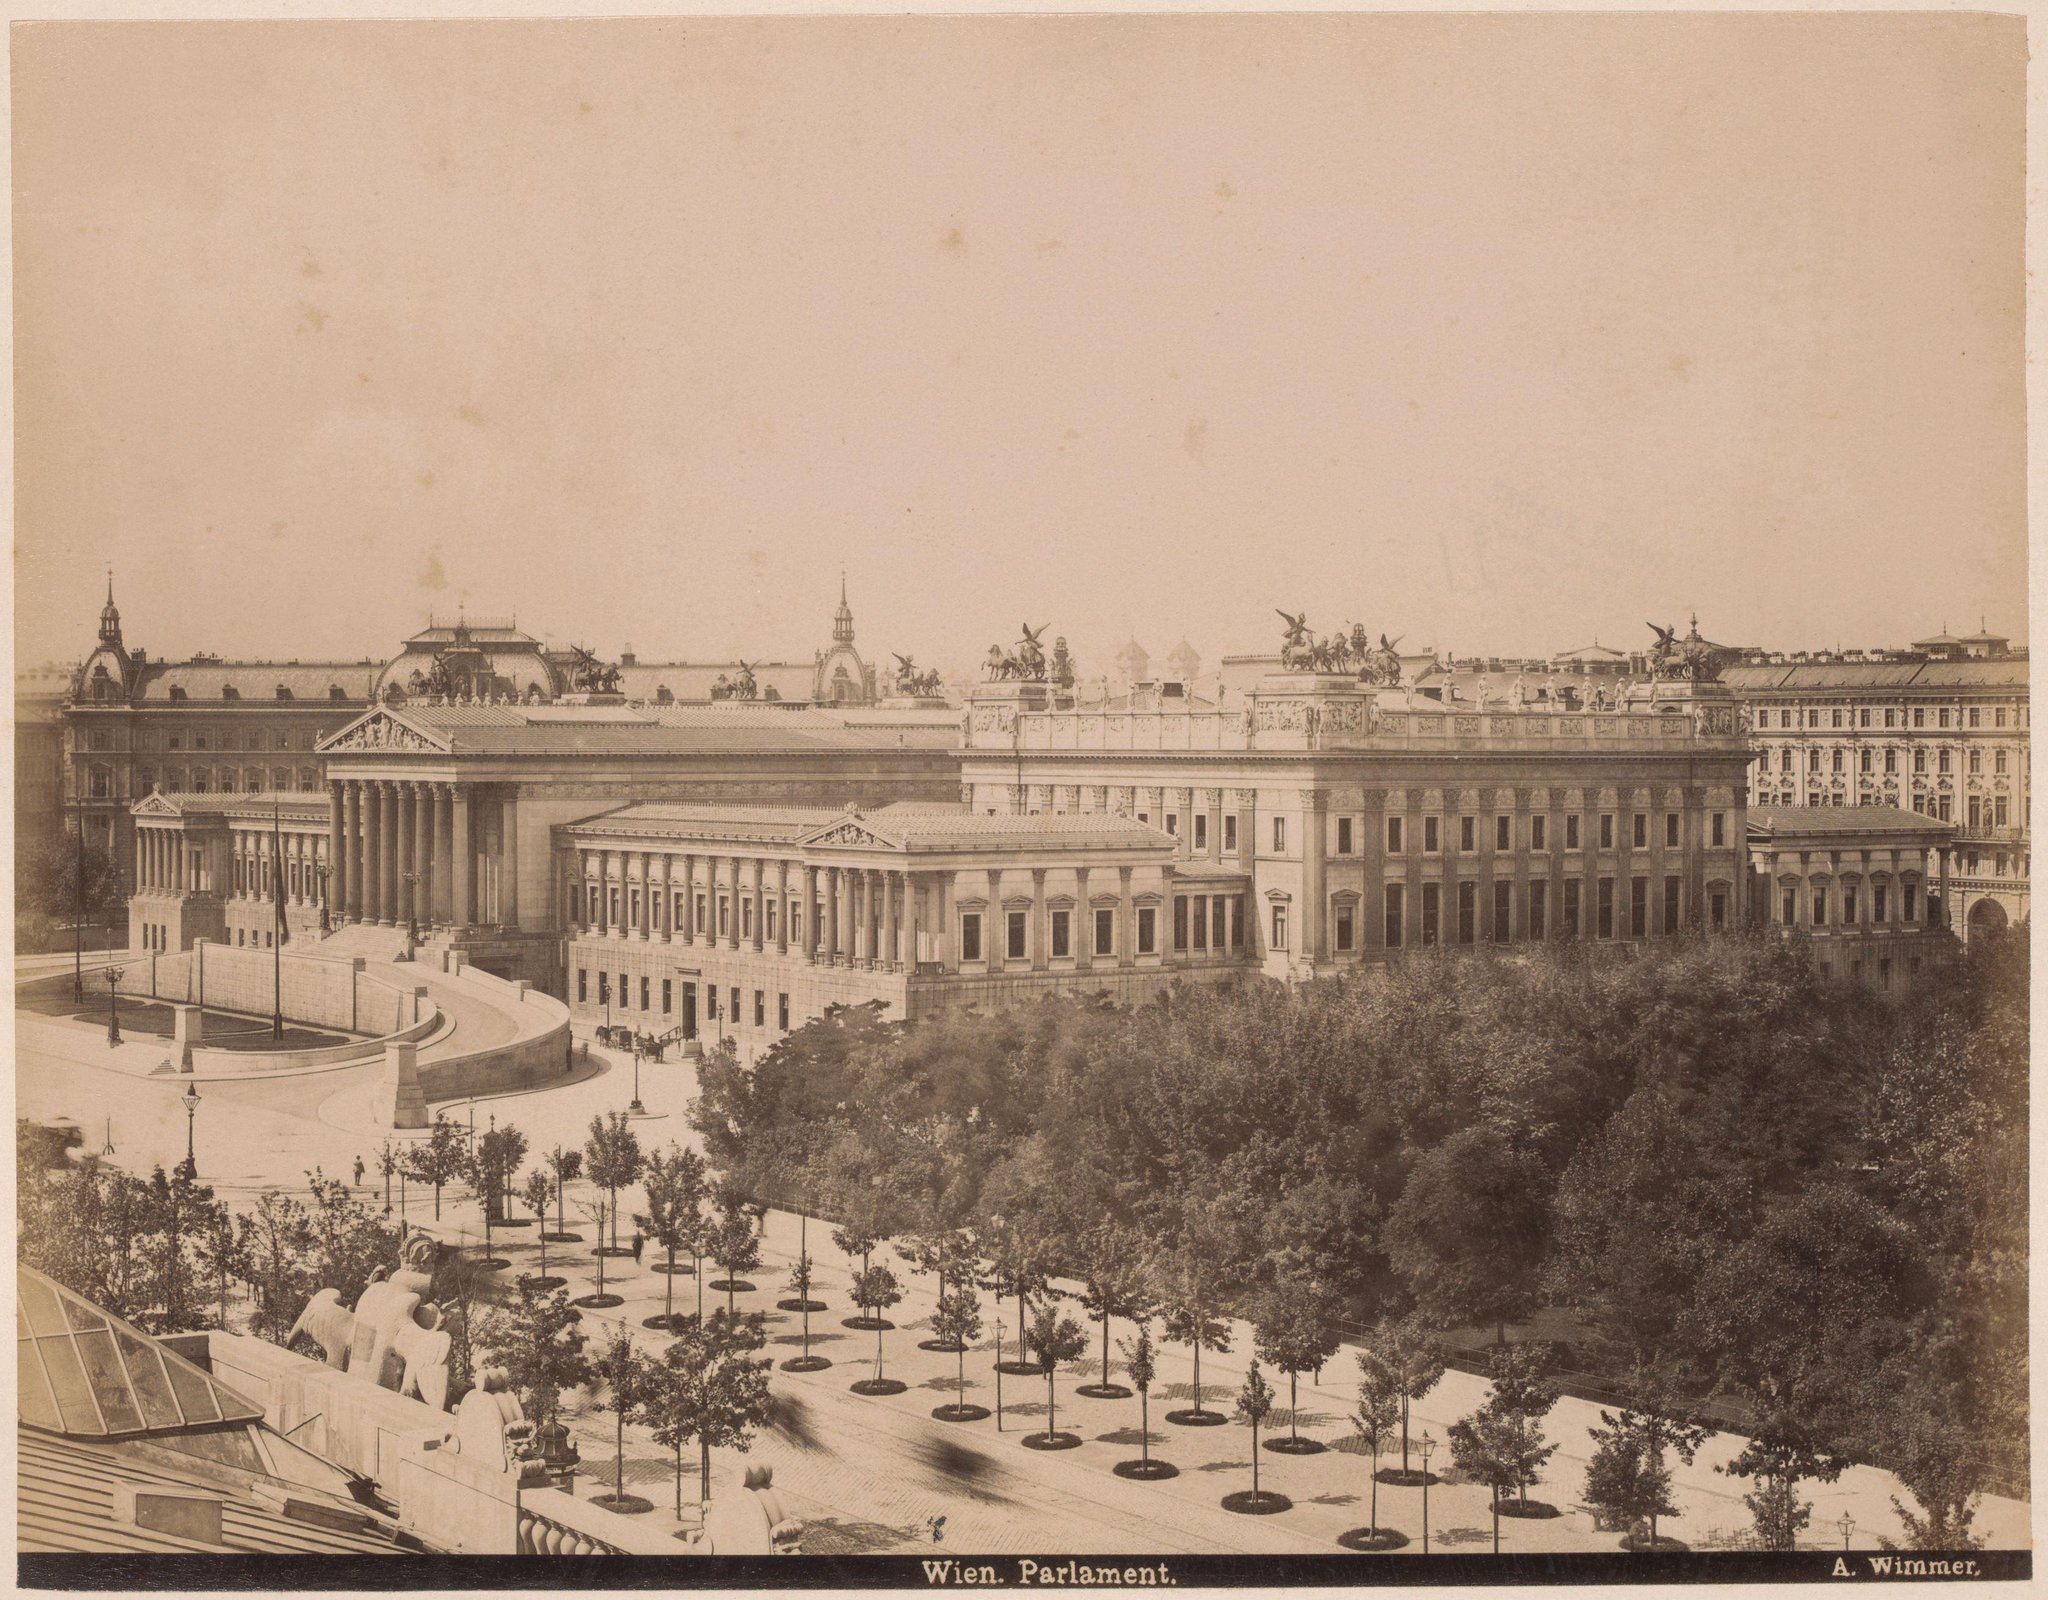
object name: photograph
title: Wien. Parlament.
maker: a. wimmer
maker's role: fotograaf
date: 1870-1900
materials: paper, photographic support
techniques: albumen print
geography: vienna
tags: exterior ~ representation of a building, street (+ city(-scape) with figures, staffage), vienna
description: Onderdeel van Reisalbum met foto's van bezienswaardigheden in Duitsland en Oostenrijk en van kunstwerken.